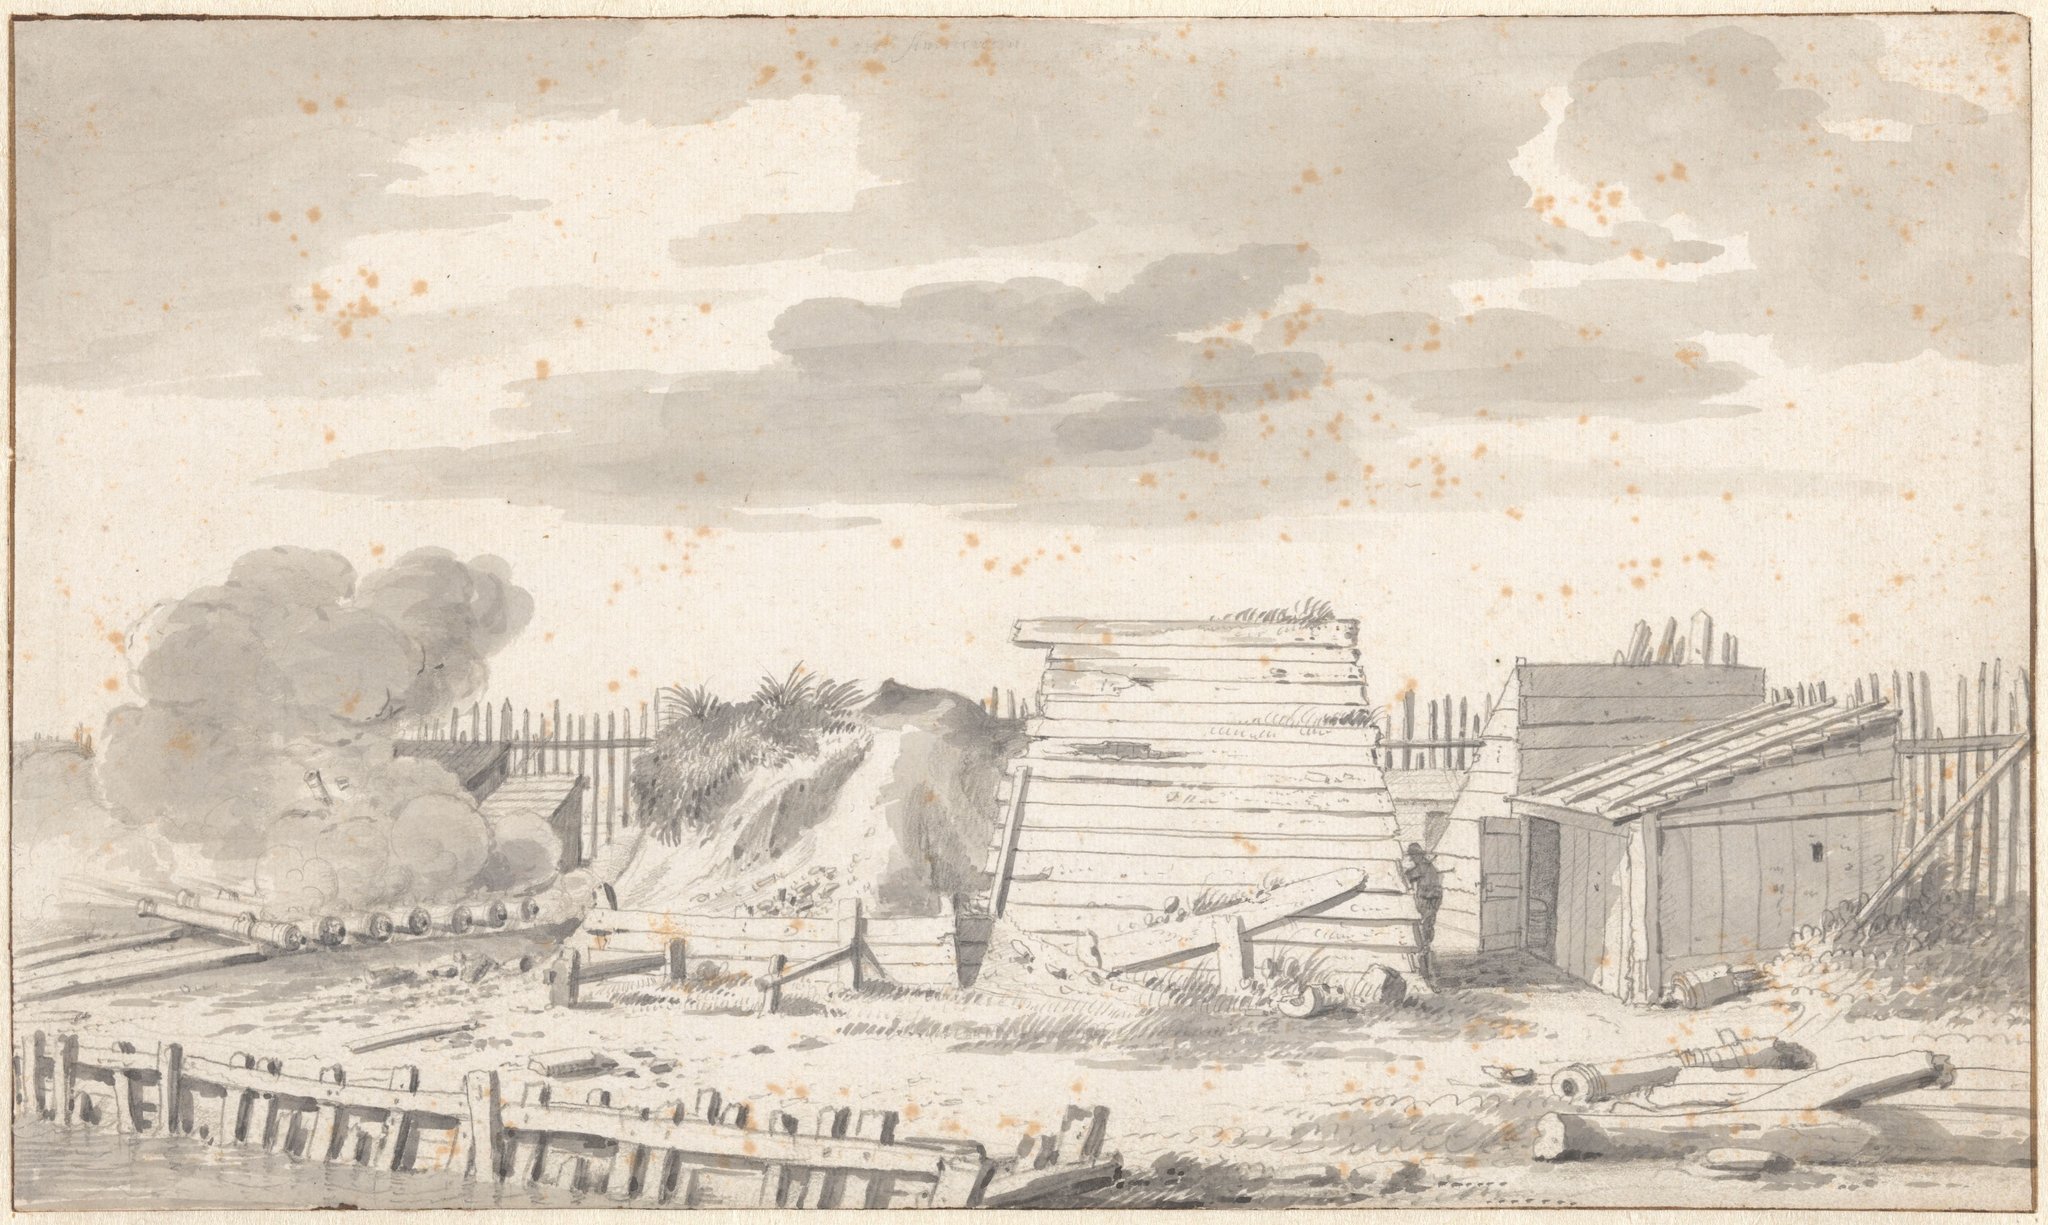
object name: drawing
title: Beproeven van kanonnen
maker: jan van der heyden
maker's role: draughtsman, painter, print maker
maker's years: 1637-1712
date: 1681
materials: ink, paper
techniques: brush, pen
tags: firearms: cannon, industries ~ metal, amsterdam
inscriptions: date: ‘1681’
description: Het beproeven van kanonnen te Amsterdam in 1681.